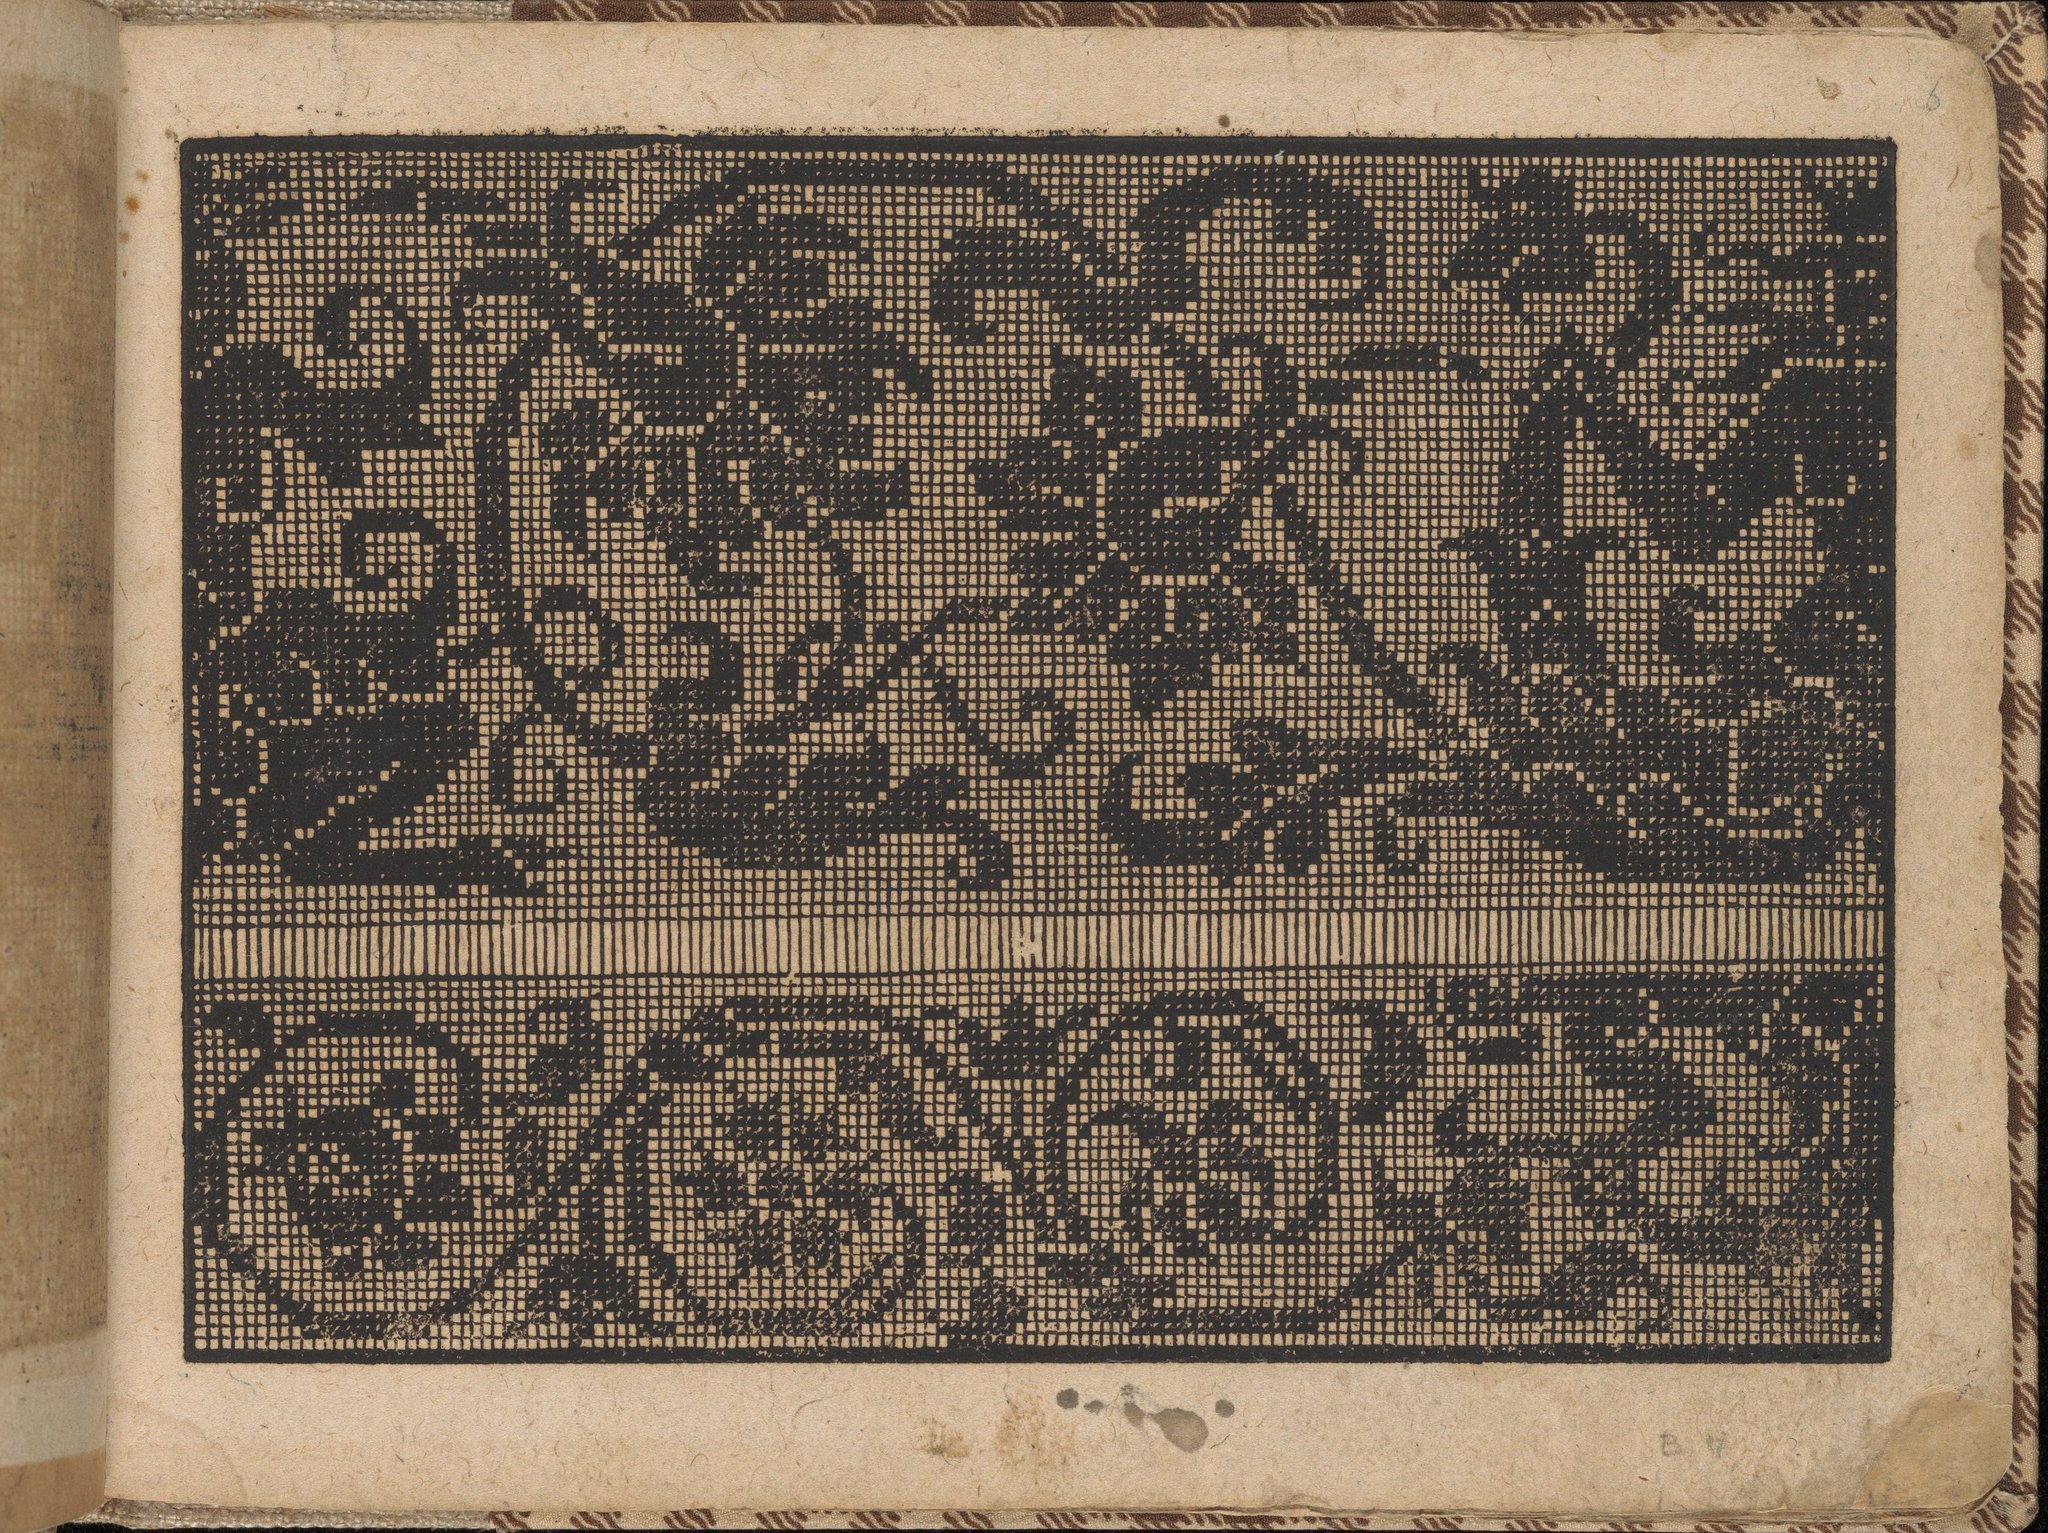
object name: book print ornament architecture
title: New Künstlichs Modelbuch (Page 6 recto)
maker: bernhard jobin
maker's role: publisher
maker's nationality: swiss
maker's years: 1535-1597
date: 1600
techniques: woodcut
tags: flowers